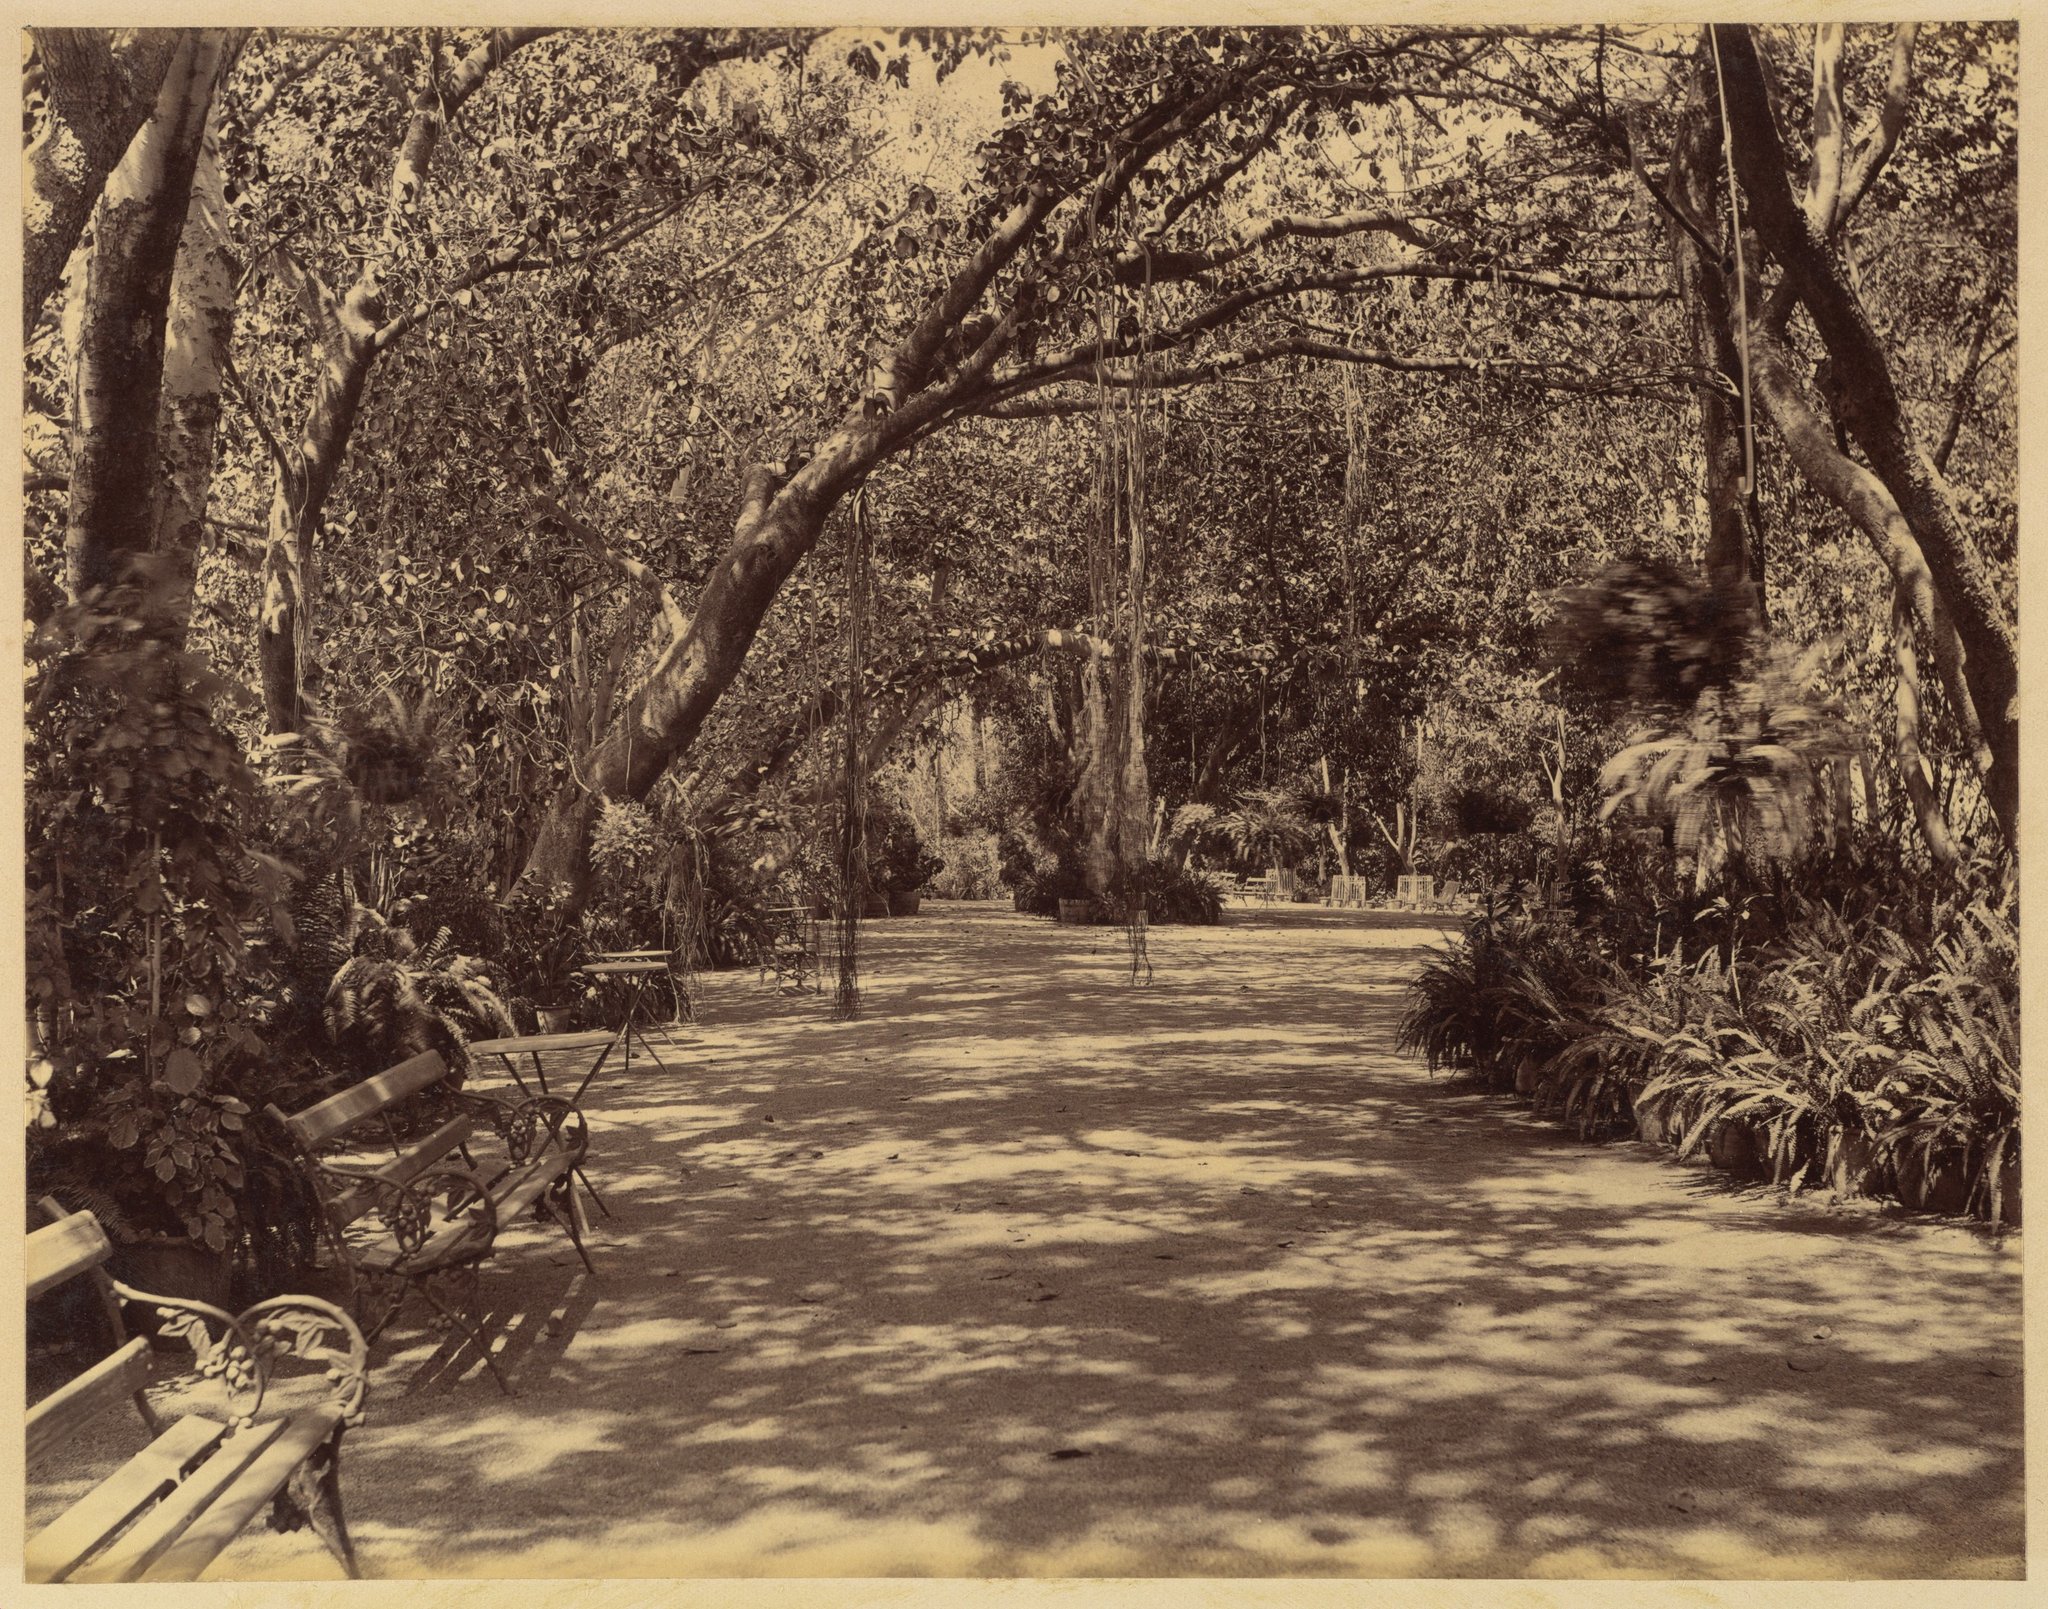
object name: photograph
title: Sookh-Vilas Palace Garden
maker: lala deen dayal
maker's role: fotograaf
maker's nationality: indian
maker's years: 1844-1910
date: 1880-1890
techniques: albumen silver print, glass negative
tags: gardens